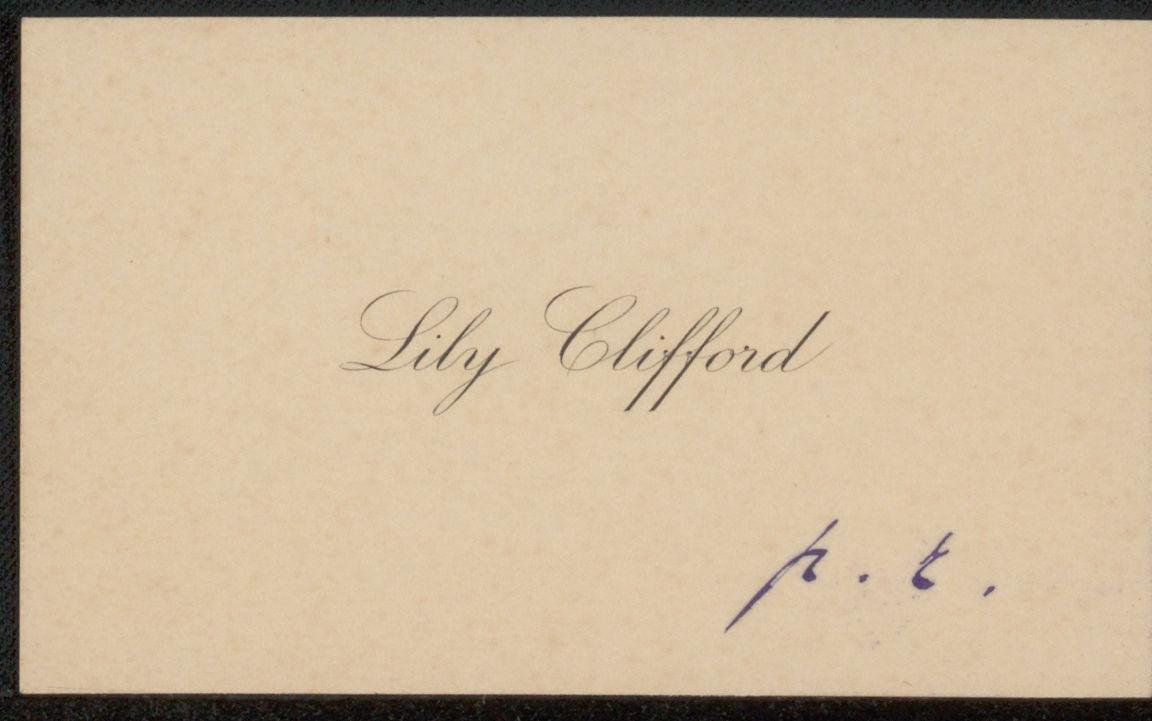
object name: visiting card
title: Visitekaartje aan Philip Zilcken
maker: jonkvrouw anna cecile aurelia jeanne clifford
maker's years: 1884-1960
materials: cardboard, ink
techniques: pen, printing, writing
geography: france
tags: painter, philip zilcken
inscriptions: collector's mark: ‘RPK’